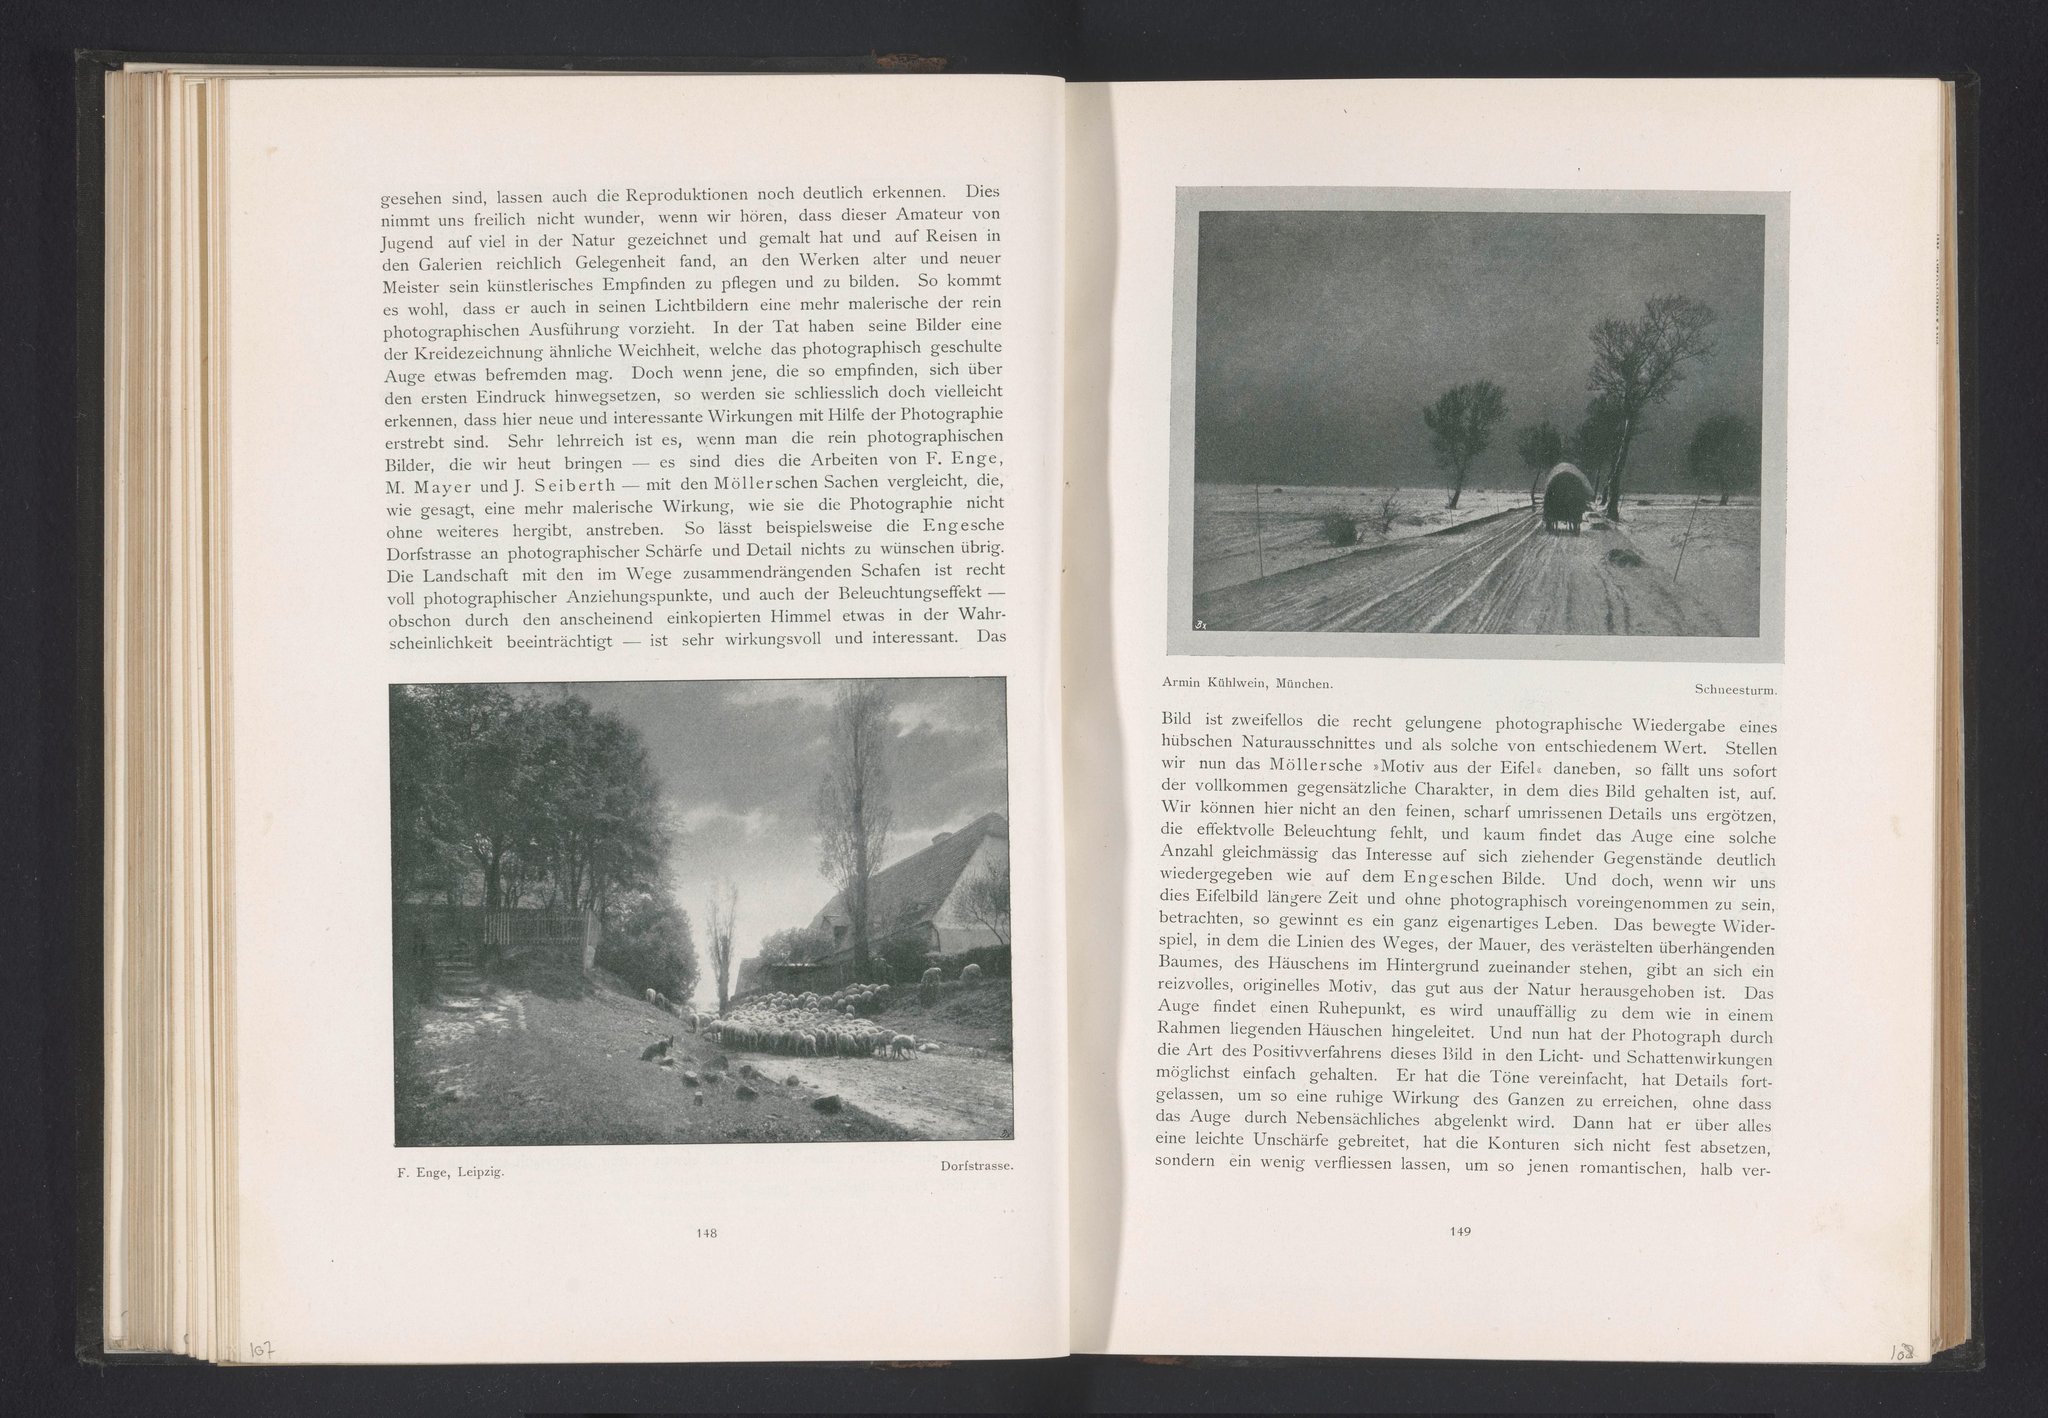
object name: page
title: Dorfstrasse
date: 1898-1903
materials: paper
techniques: autotype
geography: leipzig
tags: village, sheep, herd, flock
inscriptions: monogram: ‘BX’